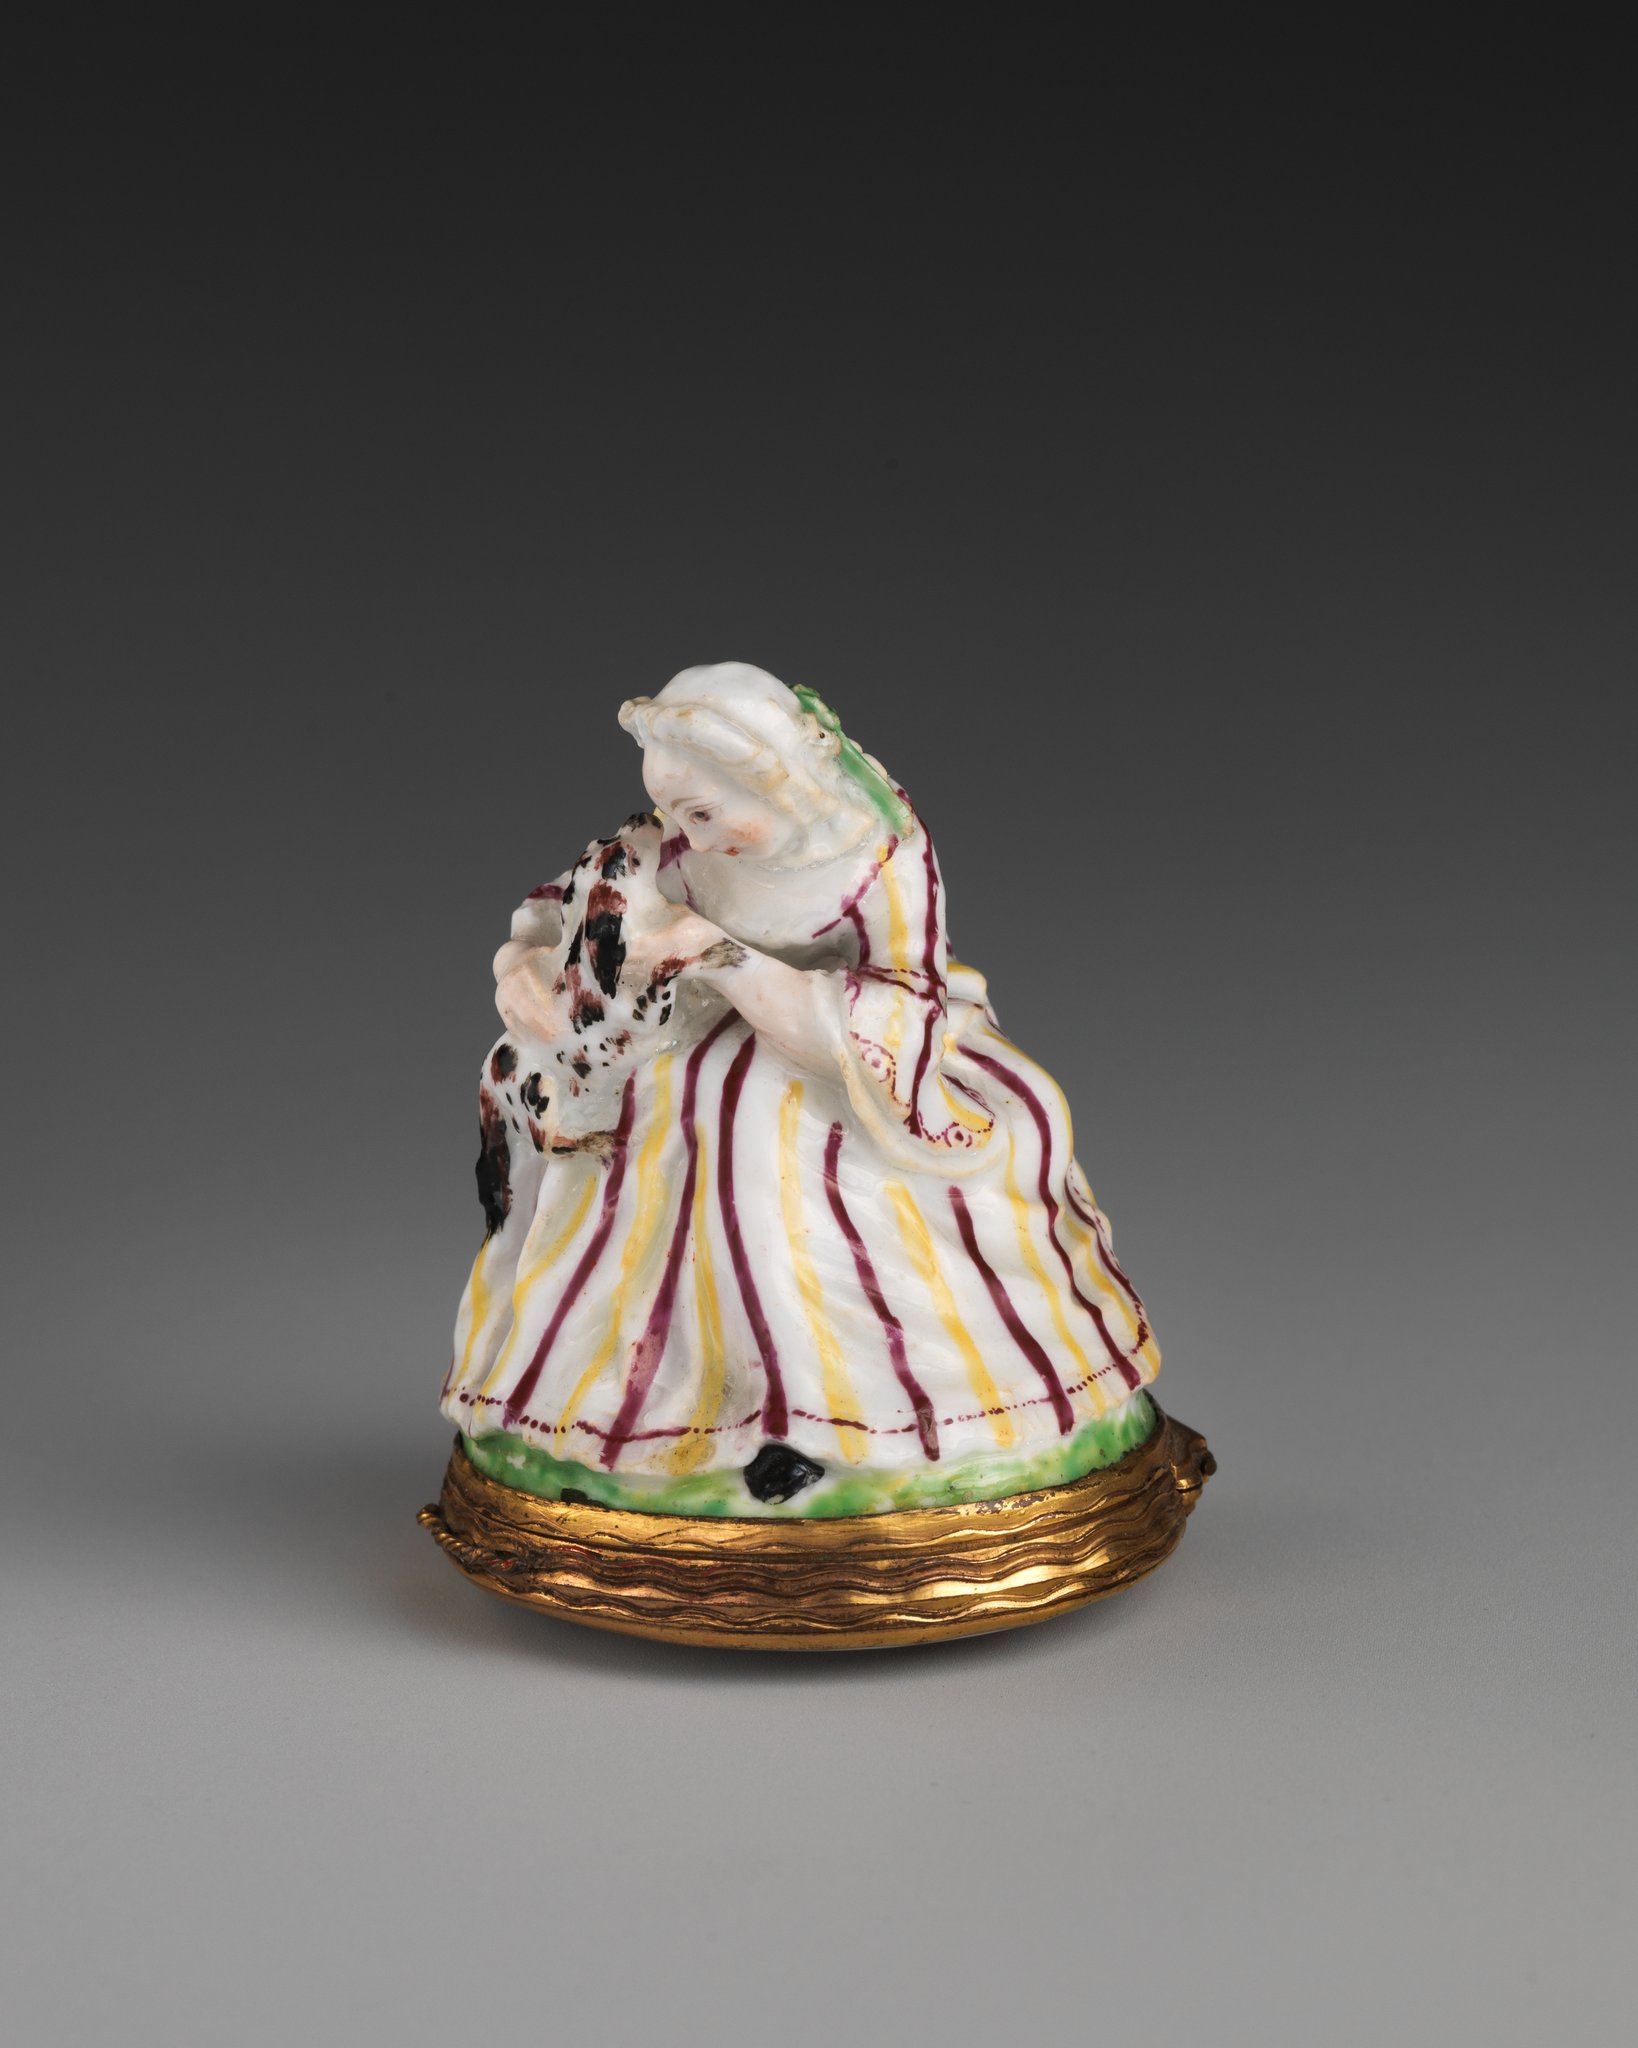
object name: toy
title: Lady with dog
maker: chelsea porcelain manufactory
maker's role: factory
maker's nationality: british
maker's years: 1744-1784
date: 1755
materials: soft paste porcelain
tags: women,dogs